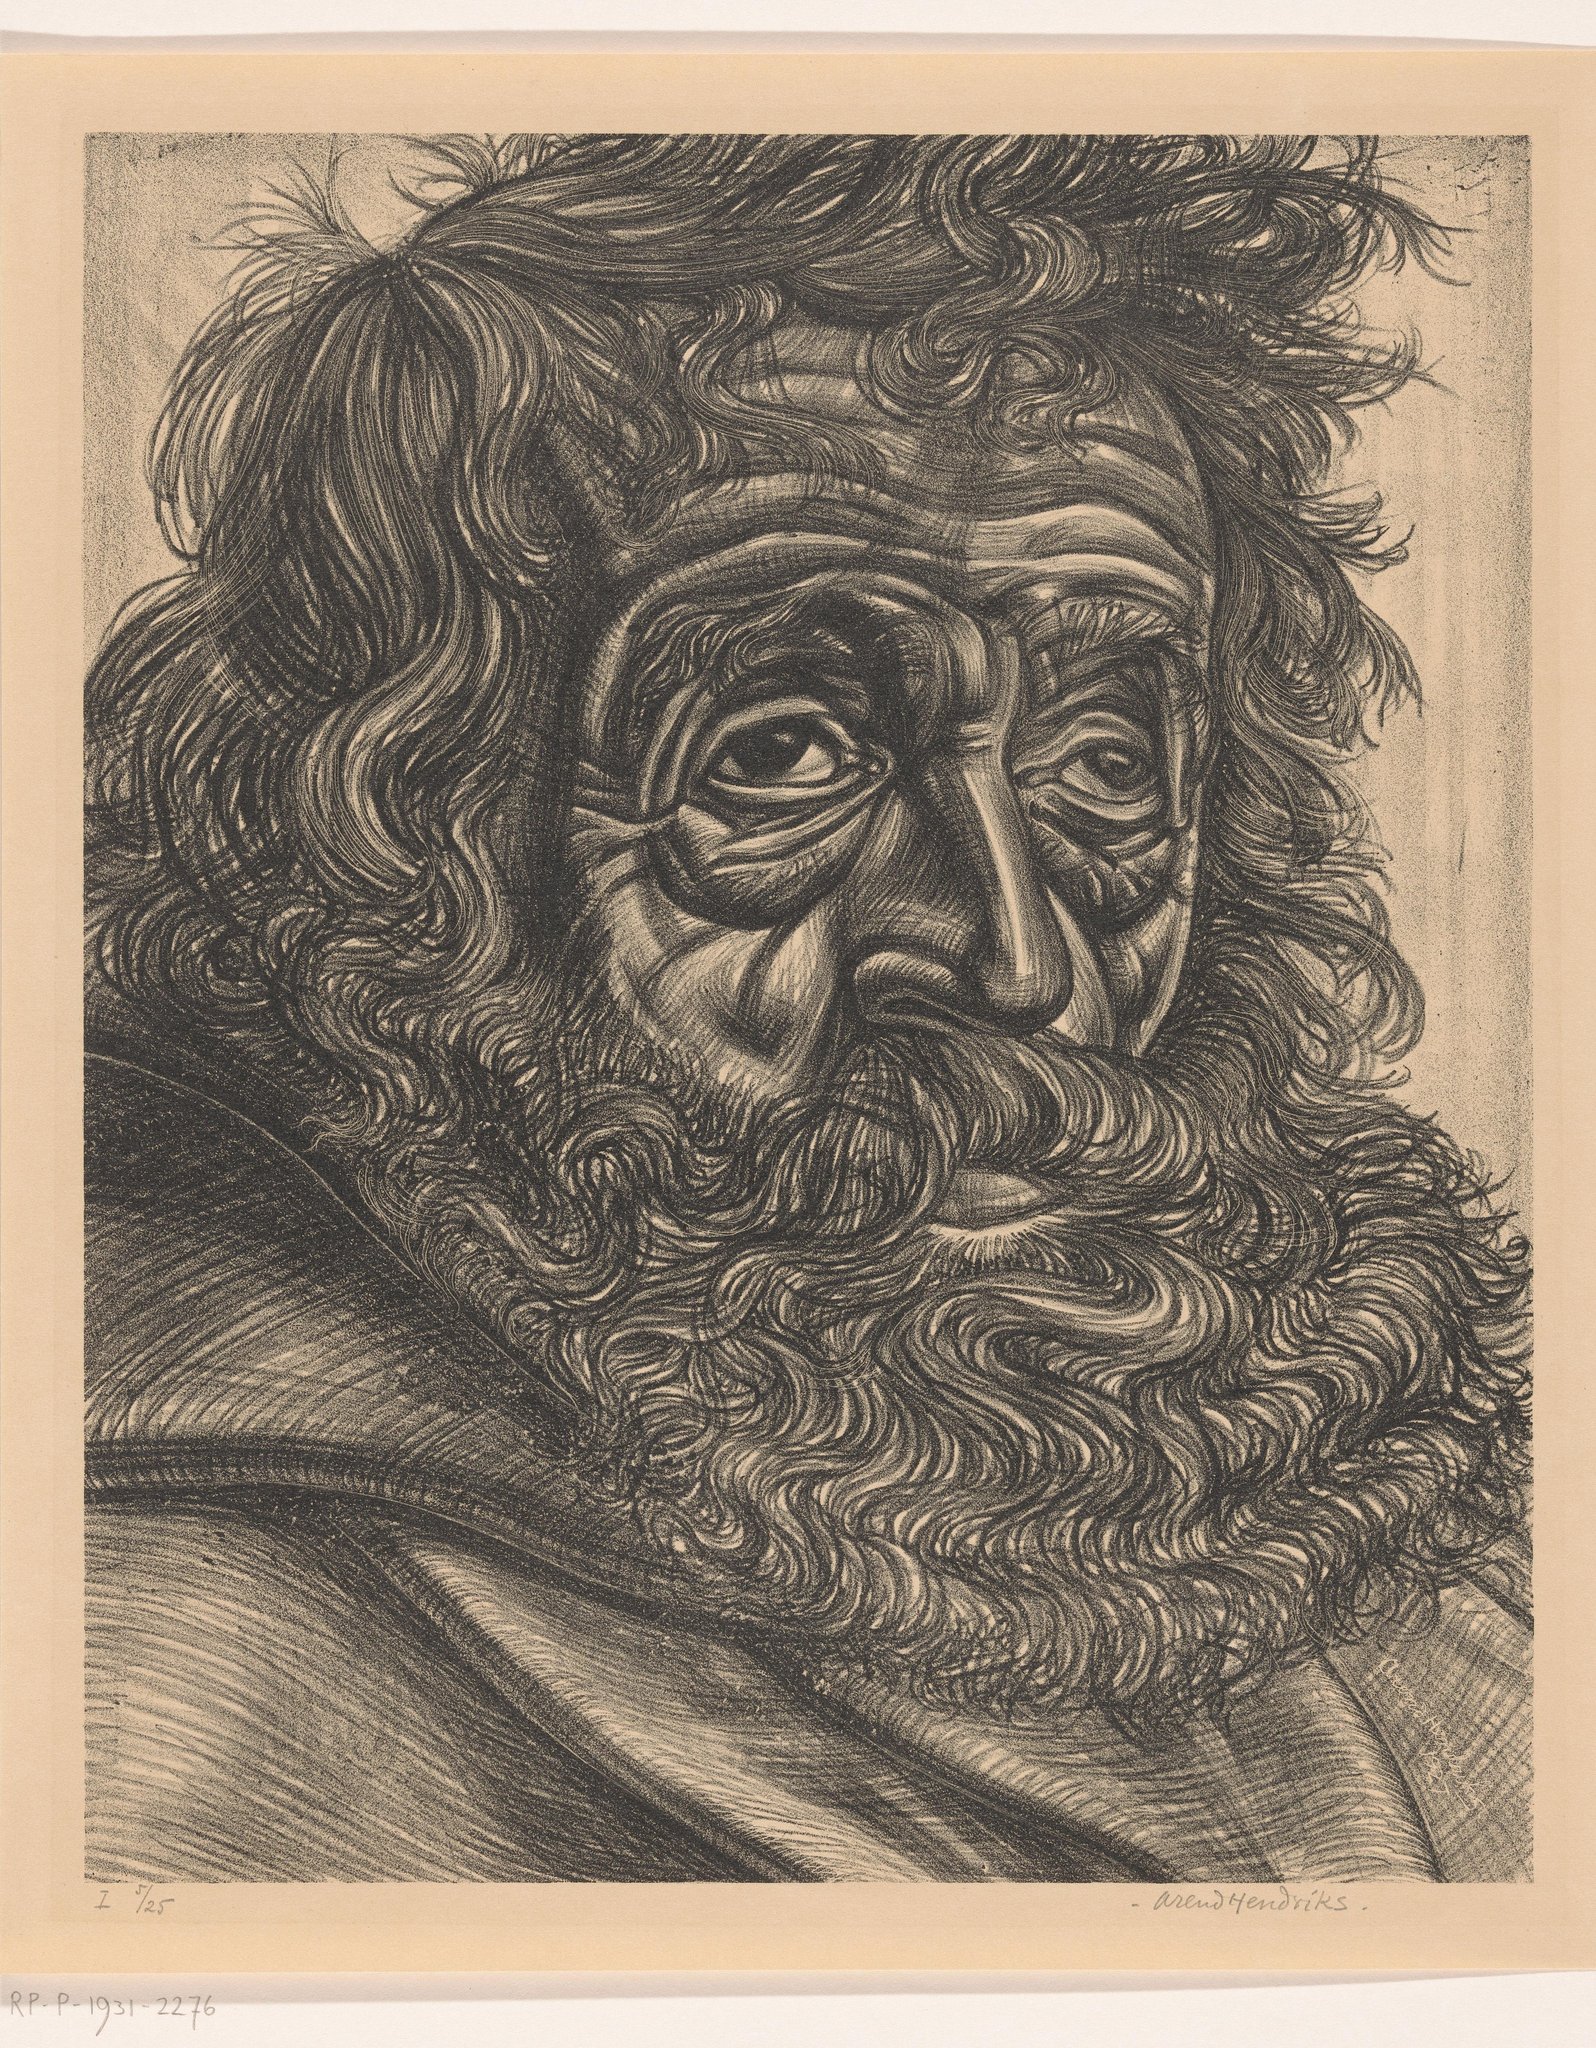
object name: print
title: Bedelmonnik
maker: arend hendriks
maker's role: print maker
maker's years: 1901-1951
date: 1927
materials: paper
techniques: lithograph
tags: monk(s), friar(s)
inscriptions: collector's mark: Lugt 2228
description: Portret van een oude bedelmonnik met baard.